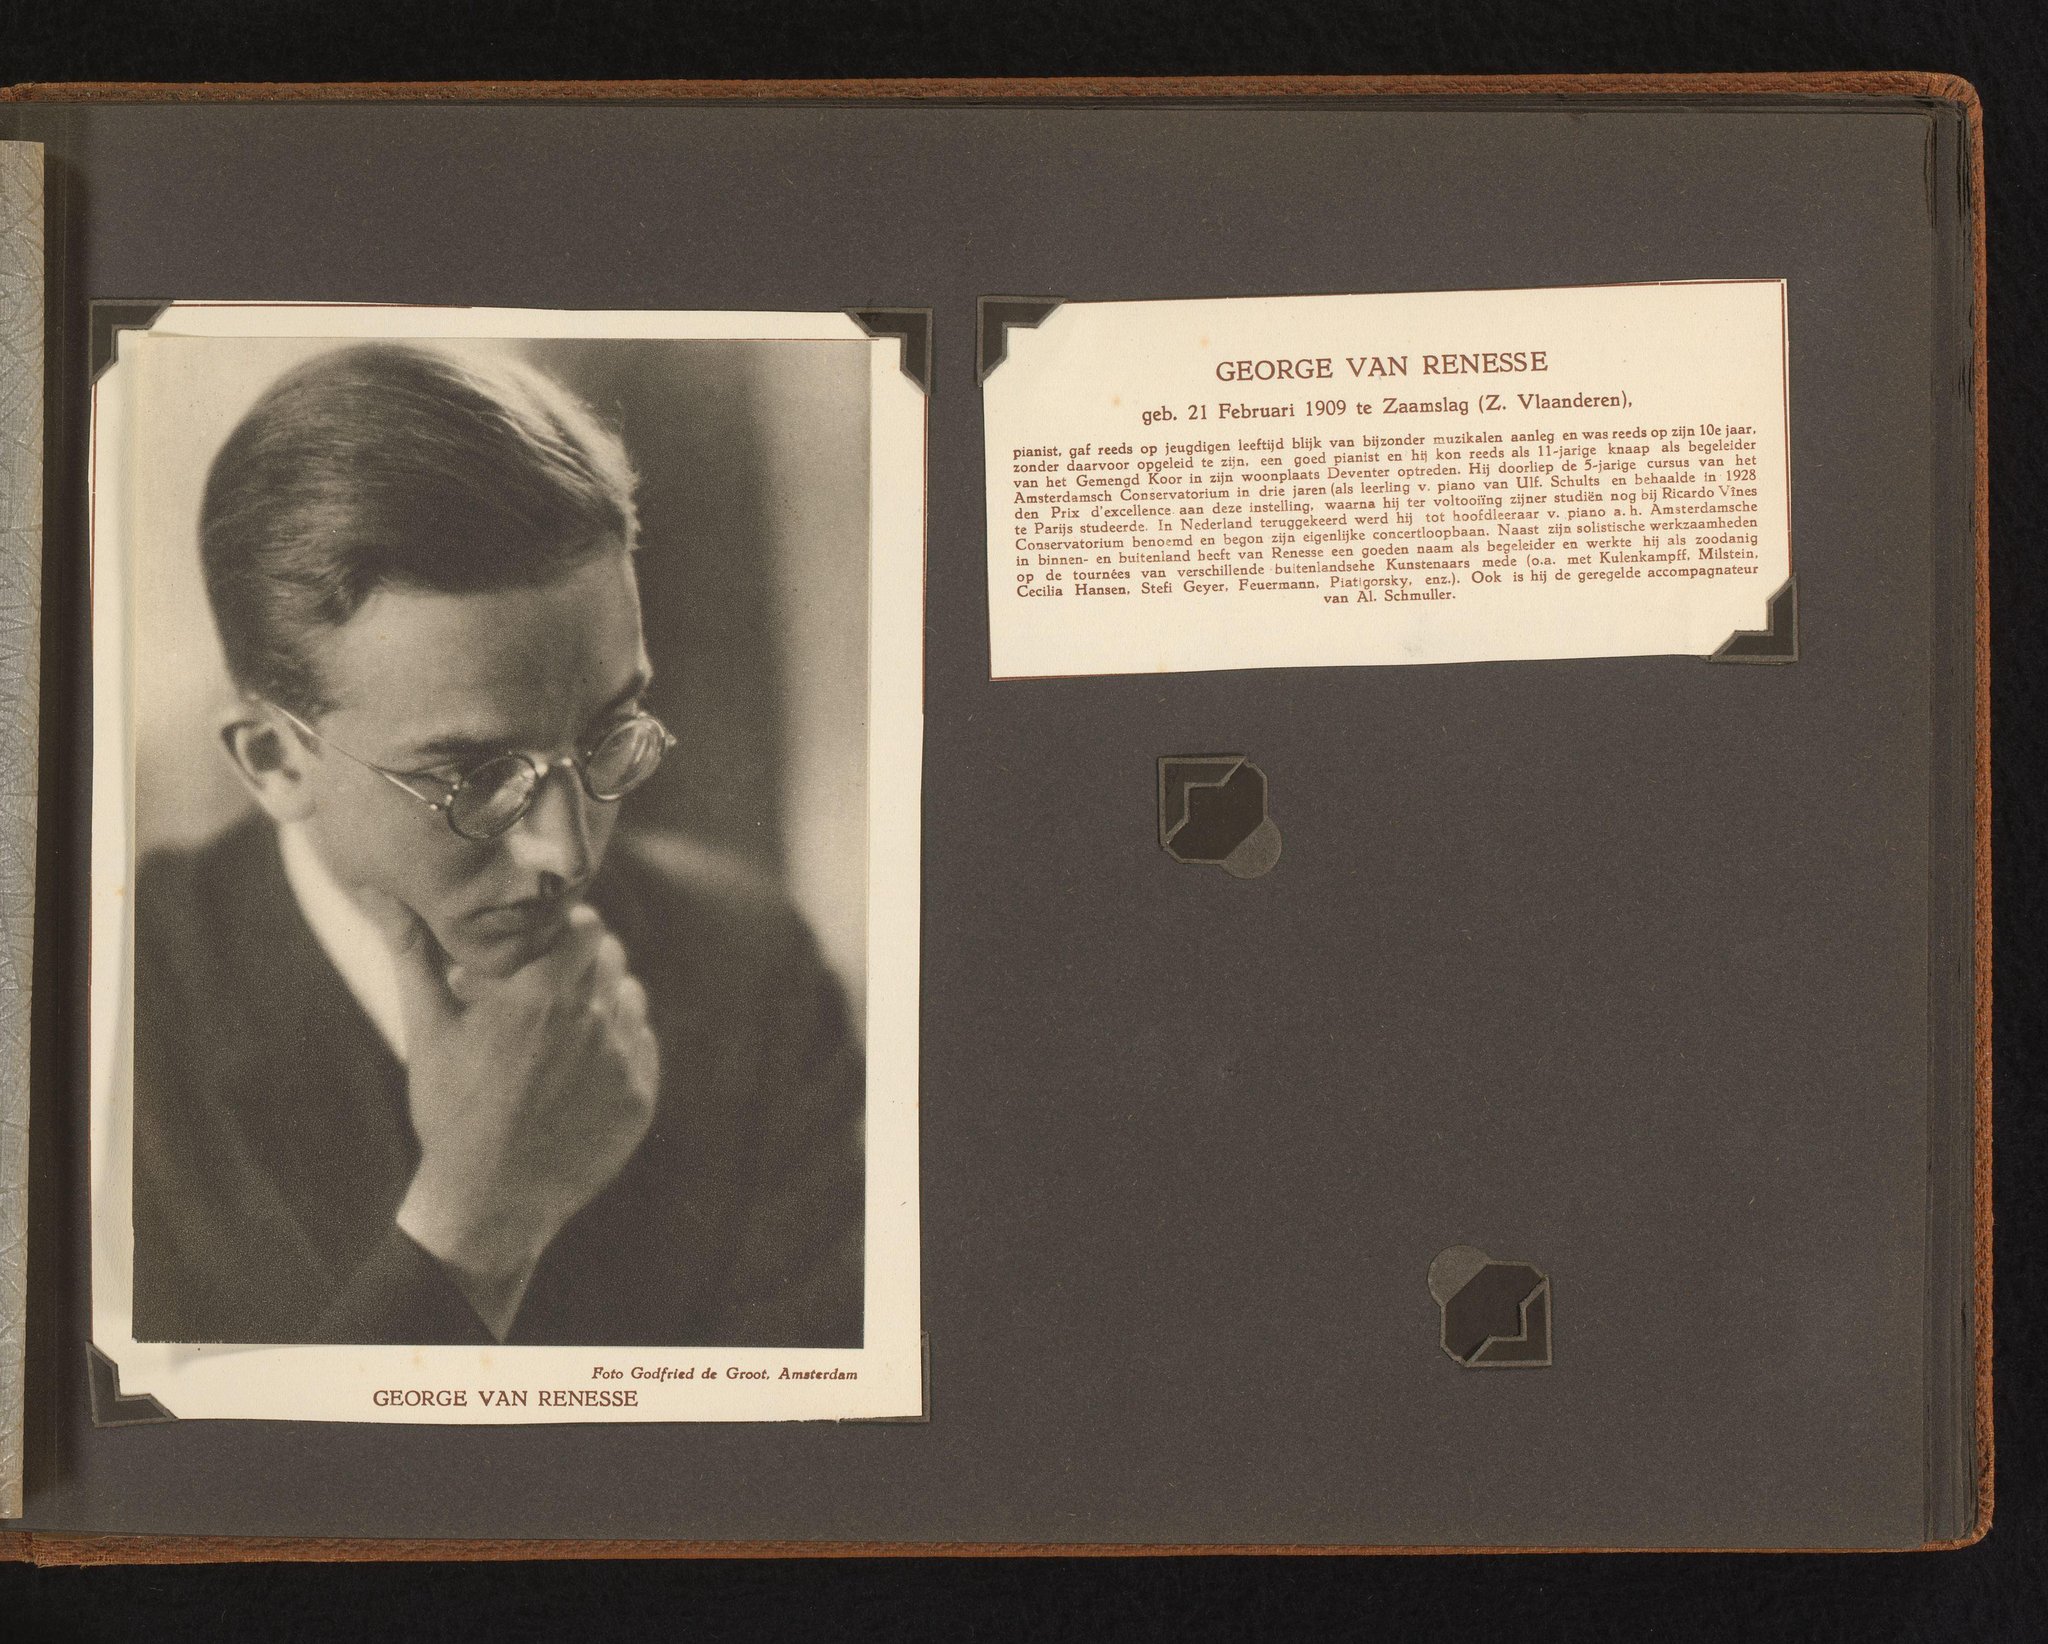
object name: album leaf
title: George van Renesse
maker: godfried de groot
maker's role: fotograaf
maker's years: 1894-1963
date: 1933-1936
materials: paper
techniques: rotogravure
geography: amsterdam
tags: musician in non-work situation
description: Albumblad met een portret van en een tekst over de pianist George van Renesse. Onderdeel van het Esperanto album uit ca. 1933-1936.